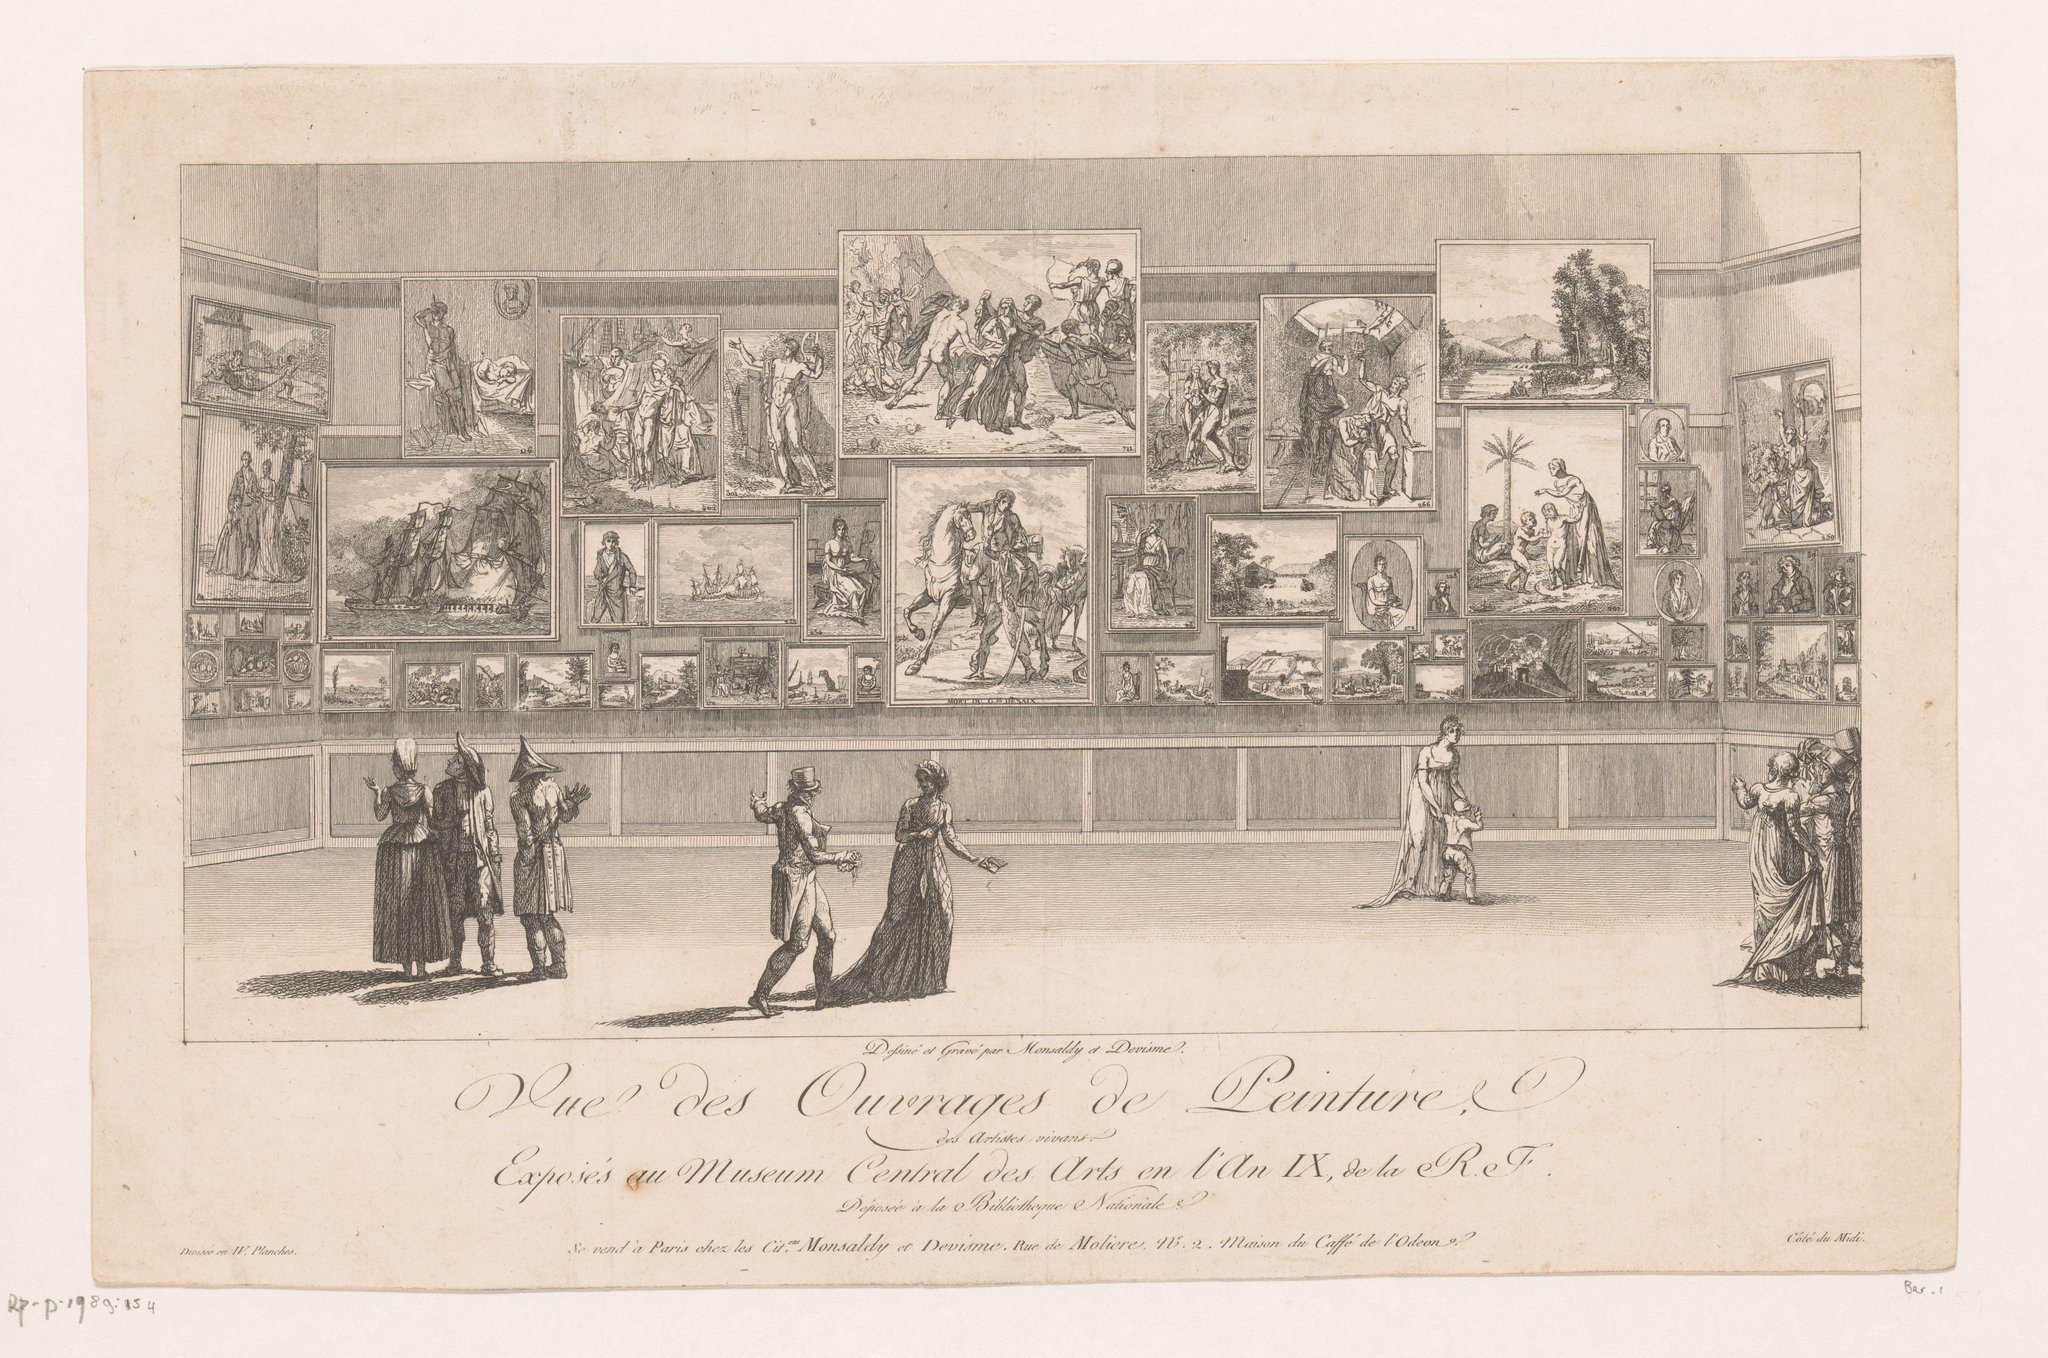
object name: print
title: Vue des ouvrages de peinture des artistes vivans. Exposés au Museum Central des Arts en l'an VIII de la R.F.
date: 1800-1801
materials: paper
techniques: etching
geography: paris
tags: permanent exhibition, museum, picture, painting, 'gemalte galerie'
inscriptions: inscription: ‘4 planches Bf [...]/ f 3800-’, collector's mark: Lugt 2228, collector's mark: Lugt 2760, : ‘Déposé à la Bibliothèque Nationale’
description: Monsaldy maakte verschillende gezichten op galerijen gedurende de Eerste Franse Republiek. Deze prent maakt deel uit van een vierdelige serie met gezichten op de schilderijengalerijen in het Musée du Louvre (Muséum central des arts de la République) van 1800-1801 (l'An IX).